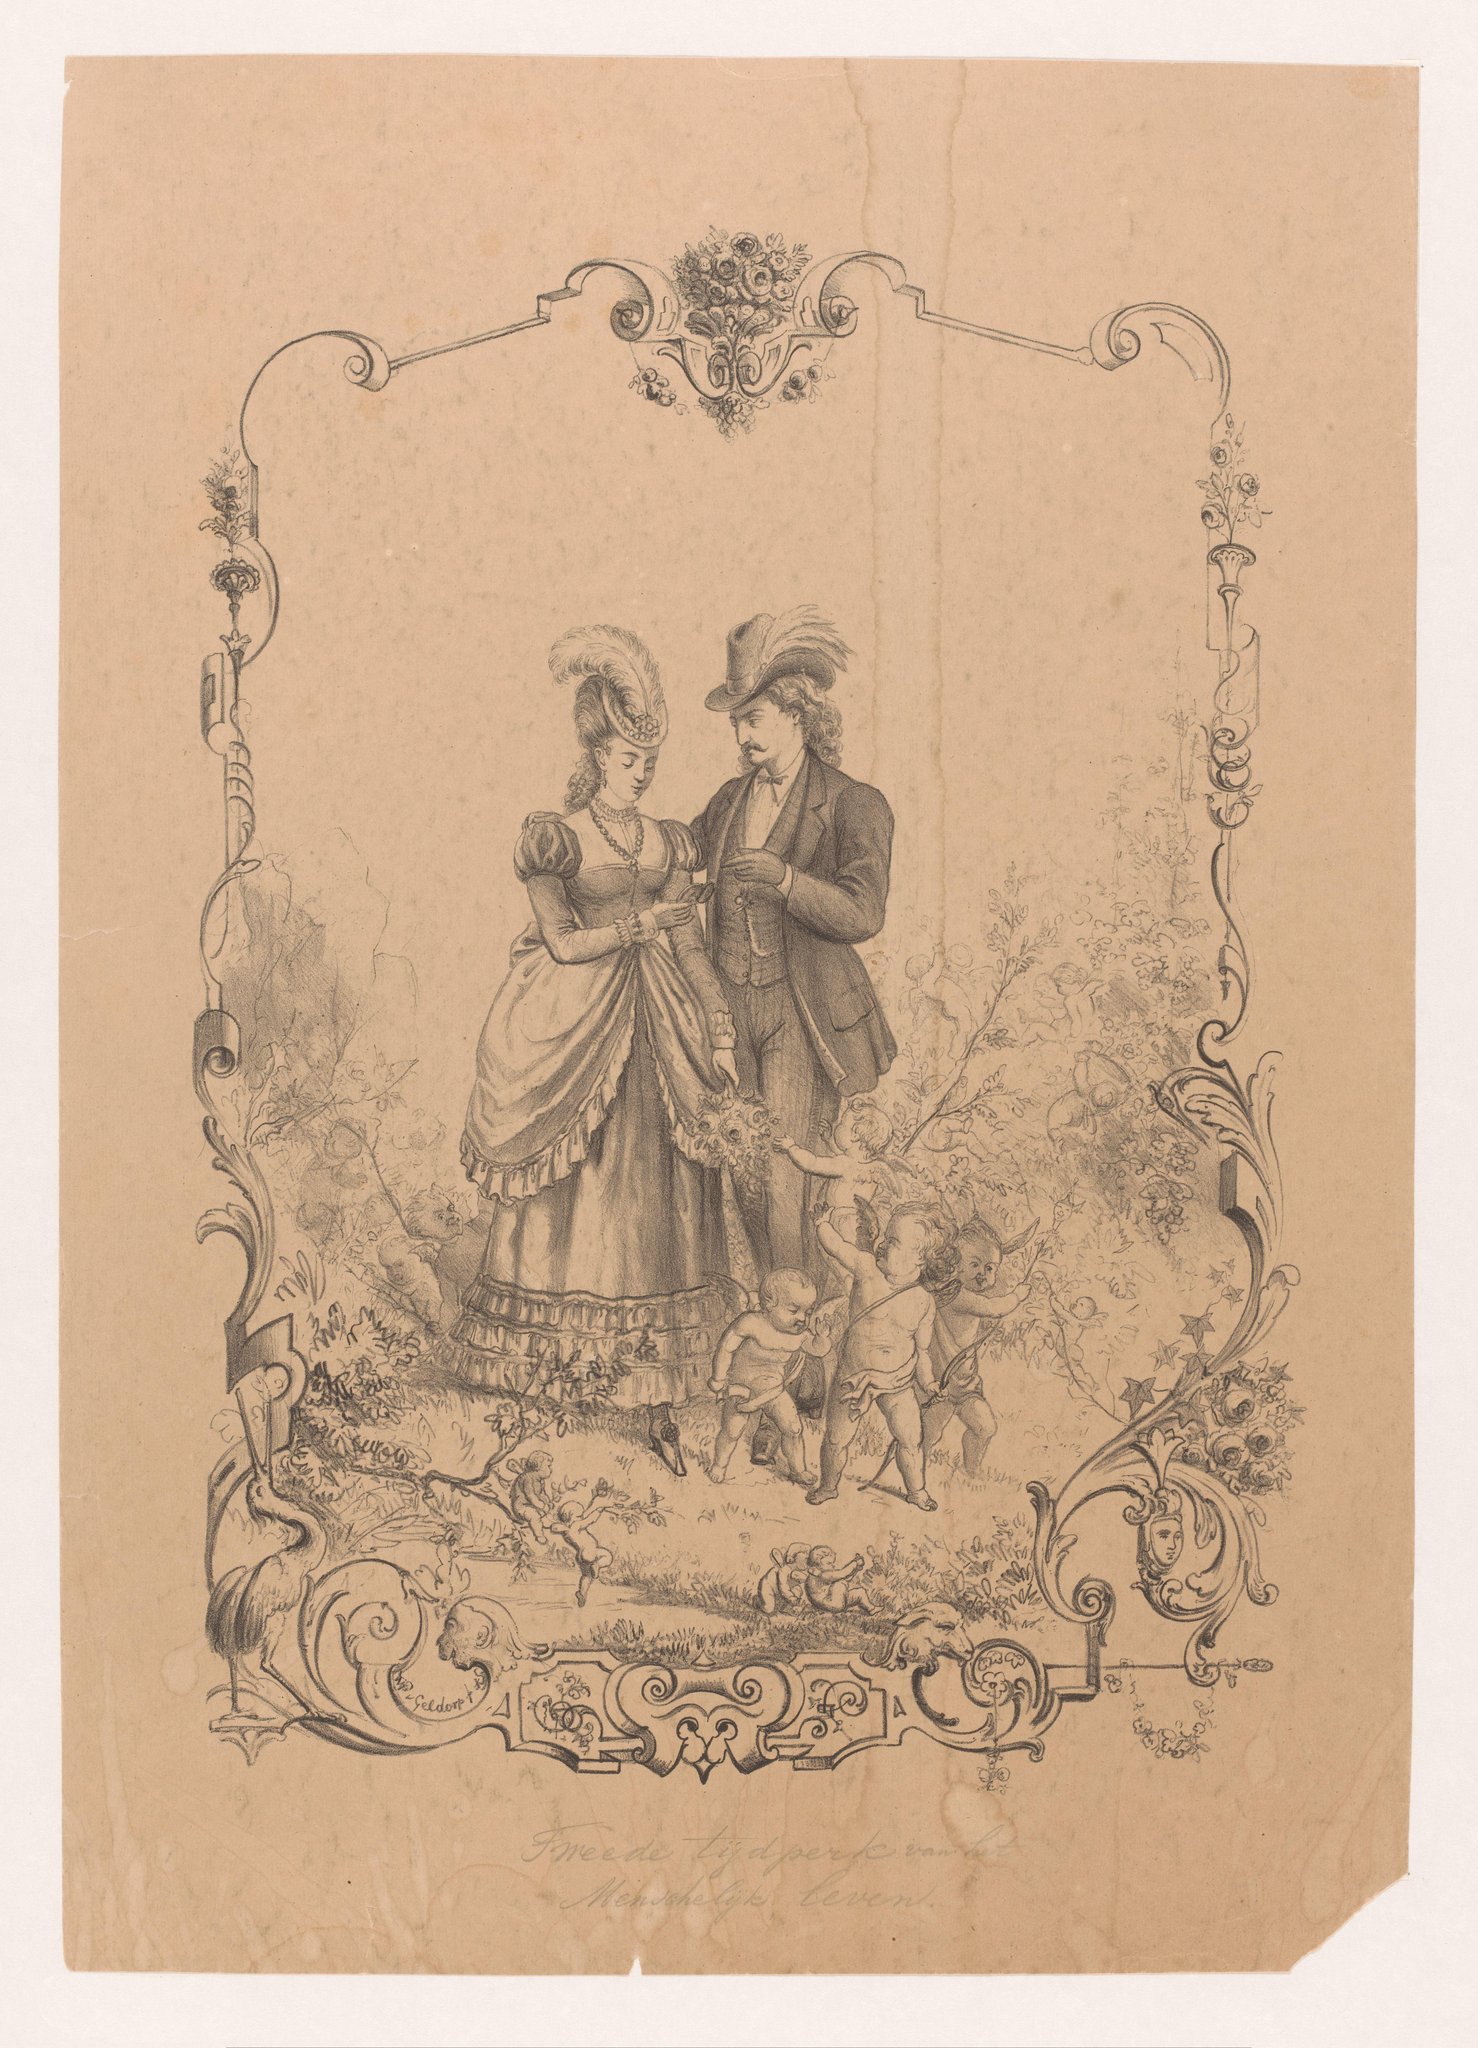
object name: print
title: Verliefd paar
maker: wilhelmus petrus van geldorp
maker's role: print maker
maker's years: 1832-1900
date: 1870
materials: paper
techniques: lithograph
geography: rotterdam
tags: shore-birds and wading-birds: stork, strolling, garden, couple of lovers, cupids: 'amores', 'amoretti', 'putti'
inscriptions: collector's mark: Lugt 2228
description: Een jonge man en vrouw lopen samen door een tuin. De man heeft zijn arm om de vrouw geslagen, de vrouw kijkt naar een spiegel of foto. Voor hen uit lopen putti. Om de afbeelding heen een sierrand met bloemen en een ooievaar.